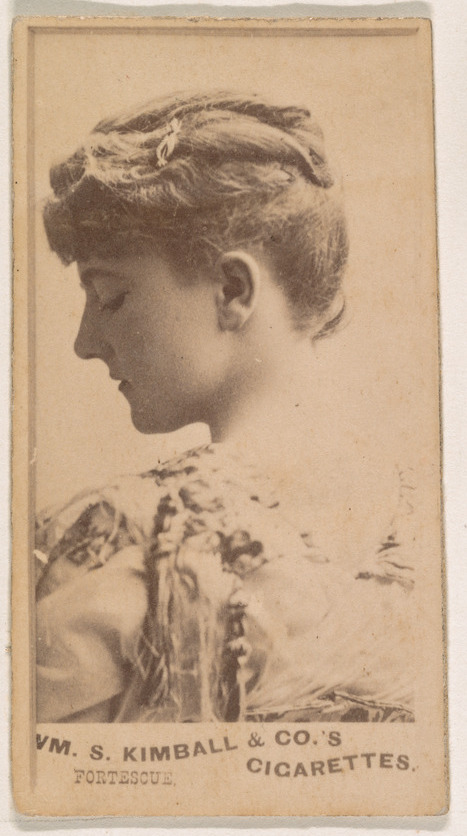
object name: photograph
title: Miss Fortescue, from the Actresses series (N203) issued by Wm. S. Kimball & Co.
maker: william s. kimball & company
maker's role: publisher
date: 1889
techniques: color lithograph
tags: portraits,women,actresses